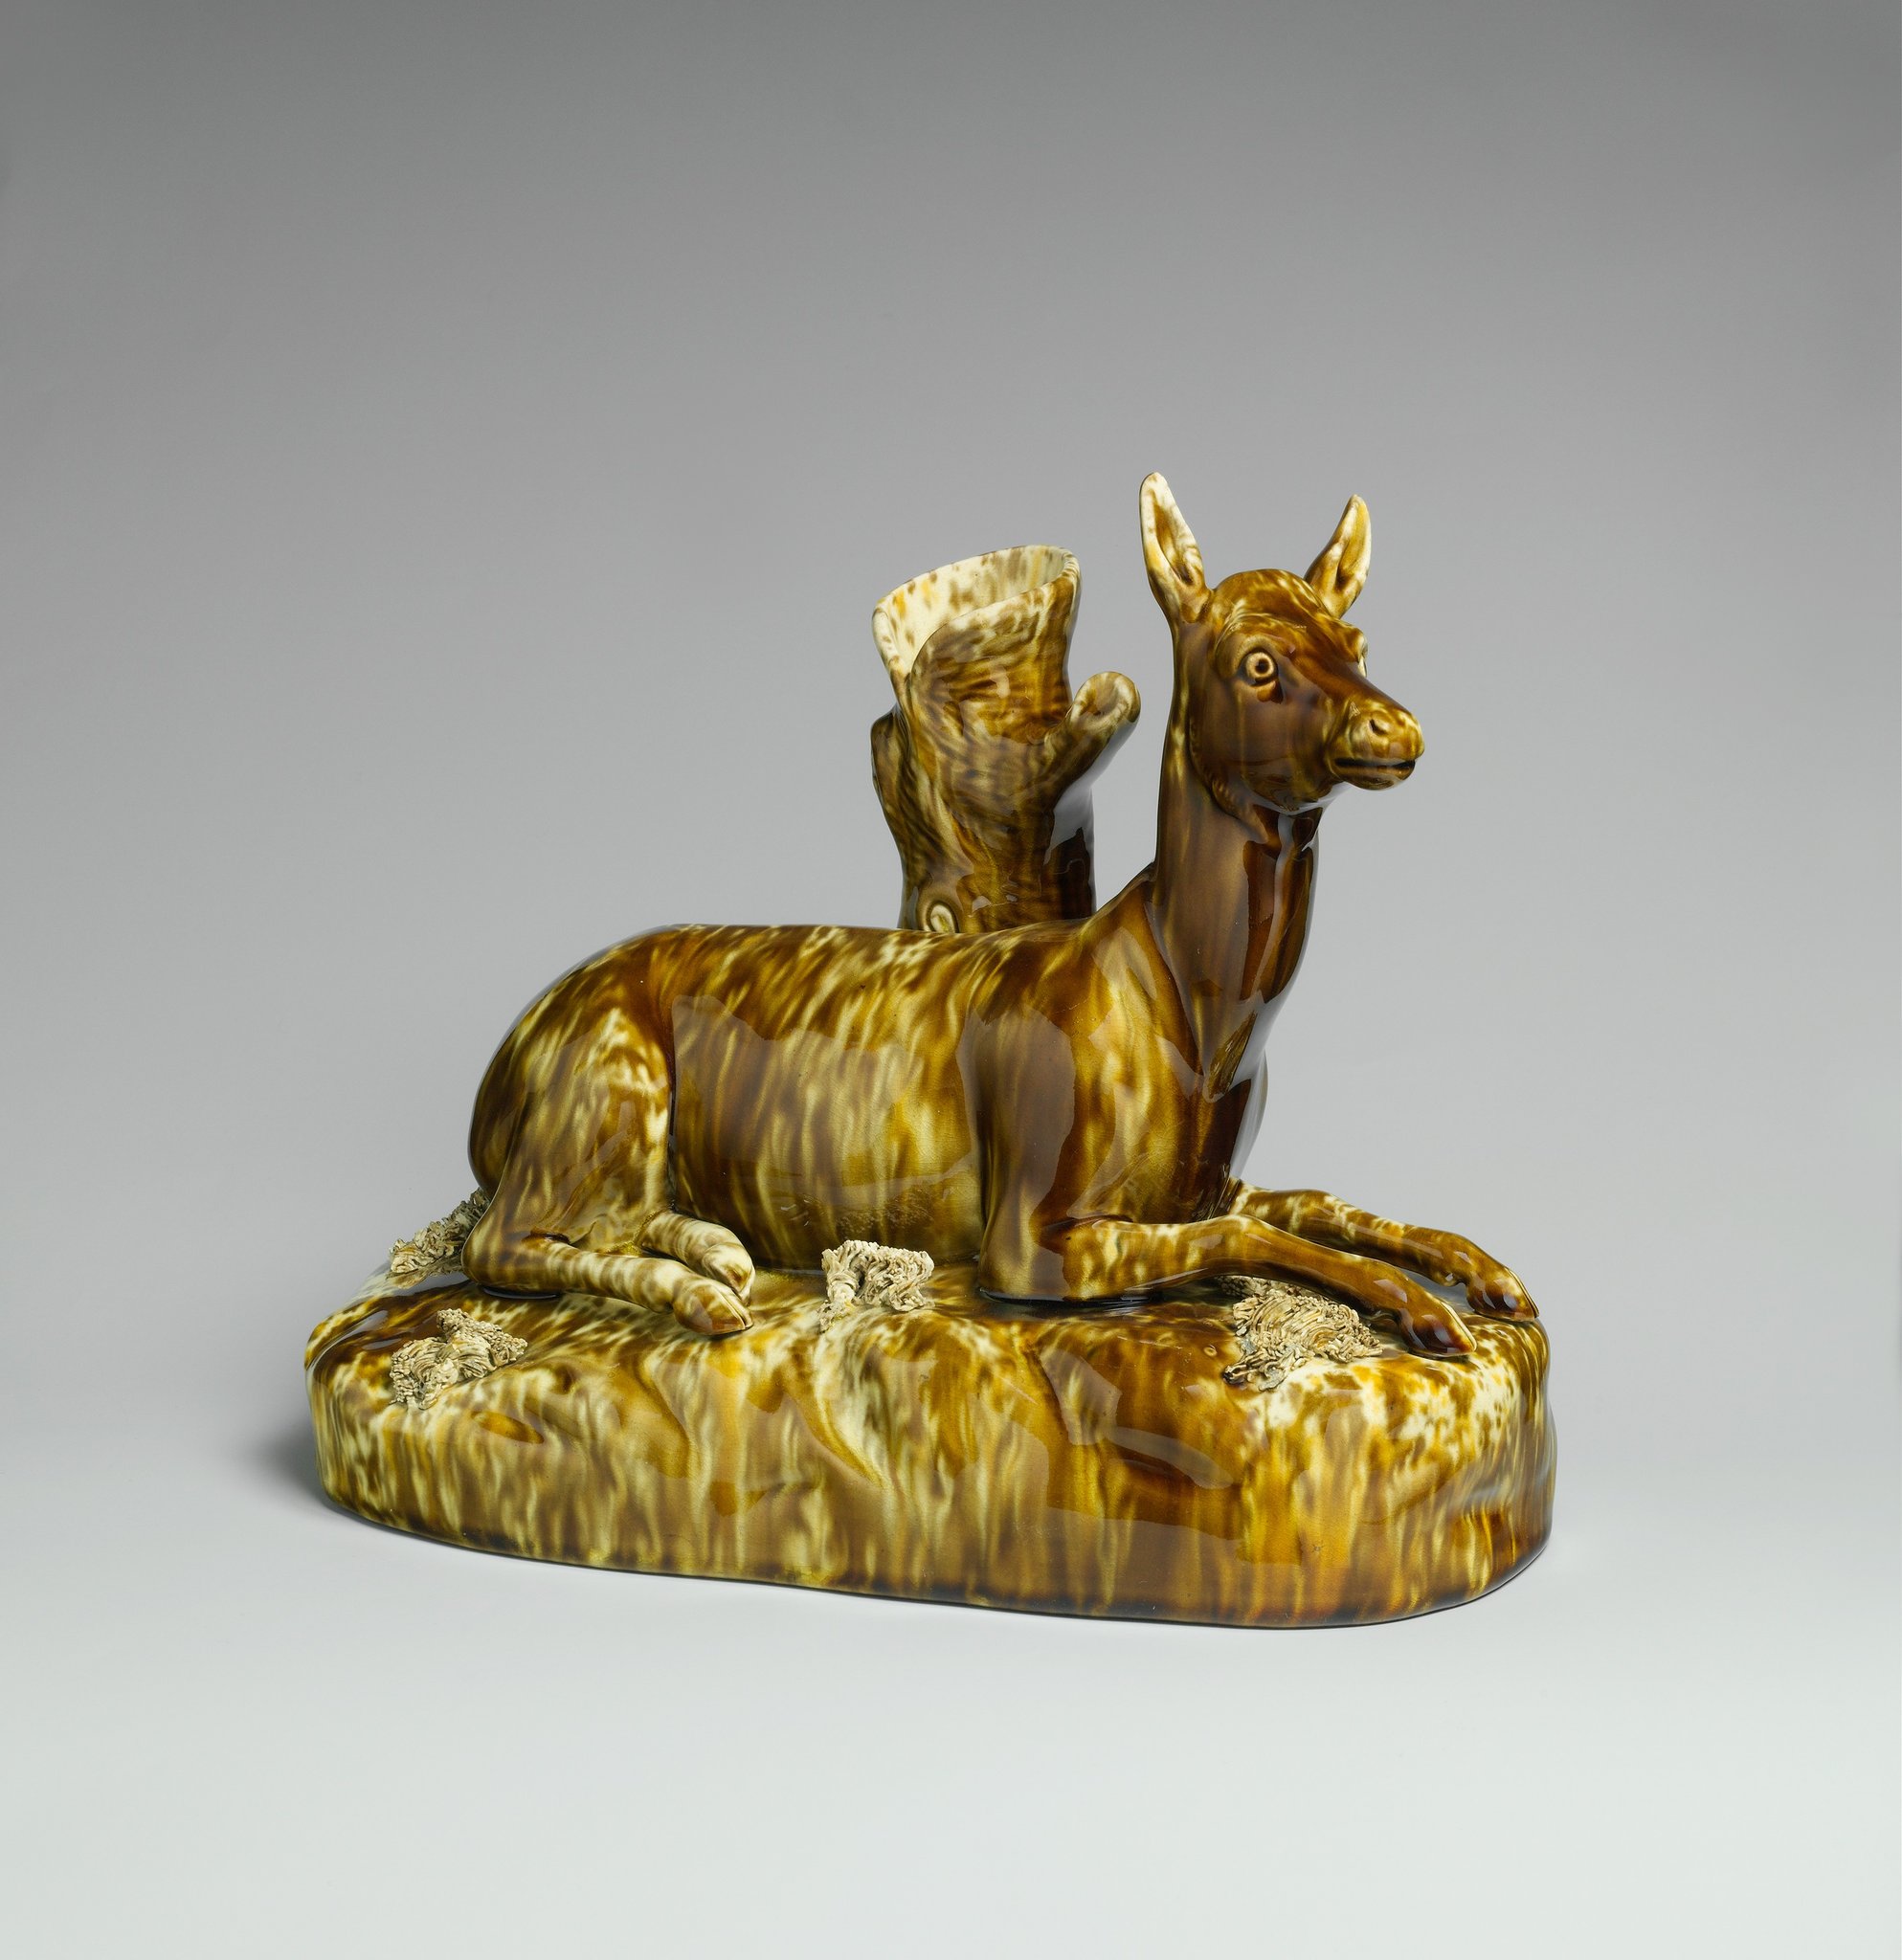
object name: figure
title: Figural spill vase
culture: american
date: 1830-1870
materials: earthenware, enamel, stone, glaze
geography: united states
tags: animals